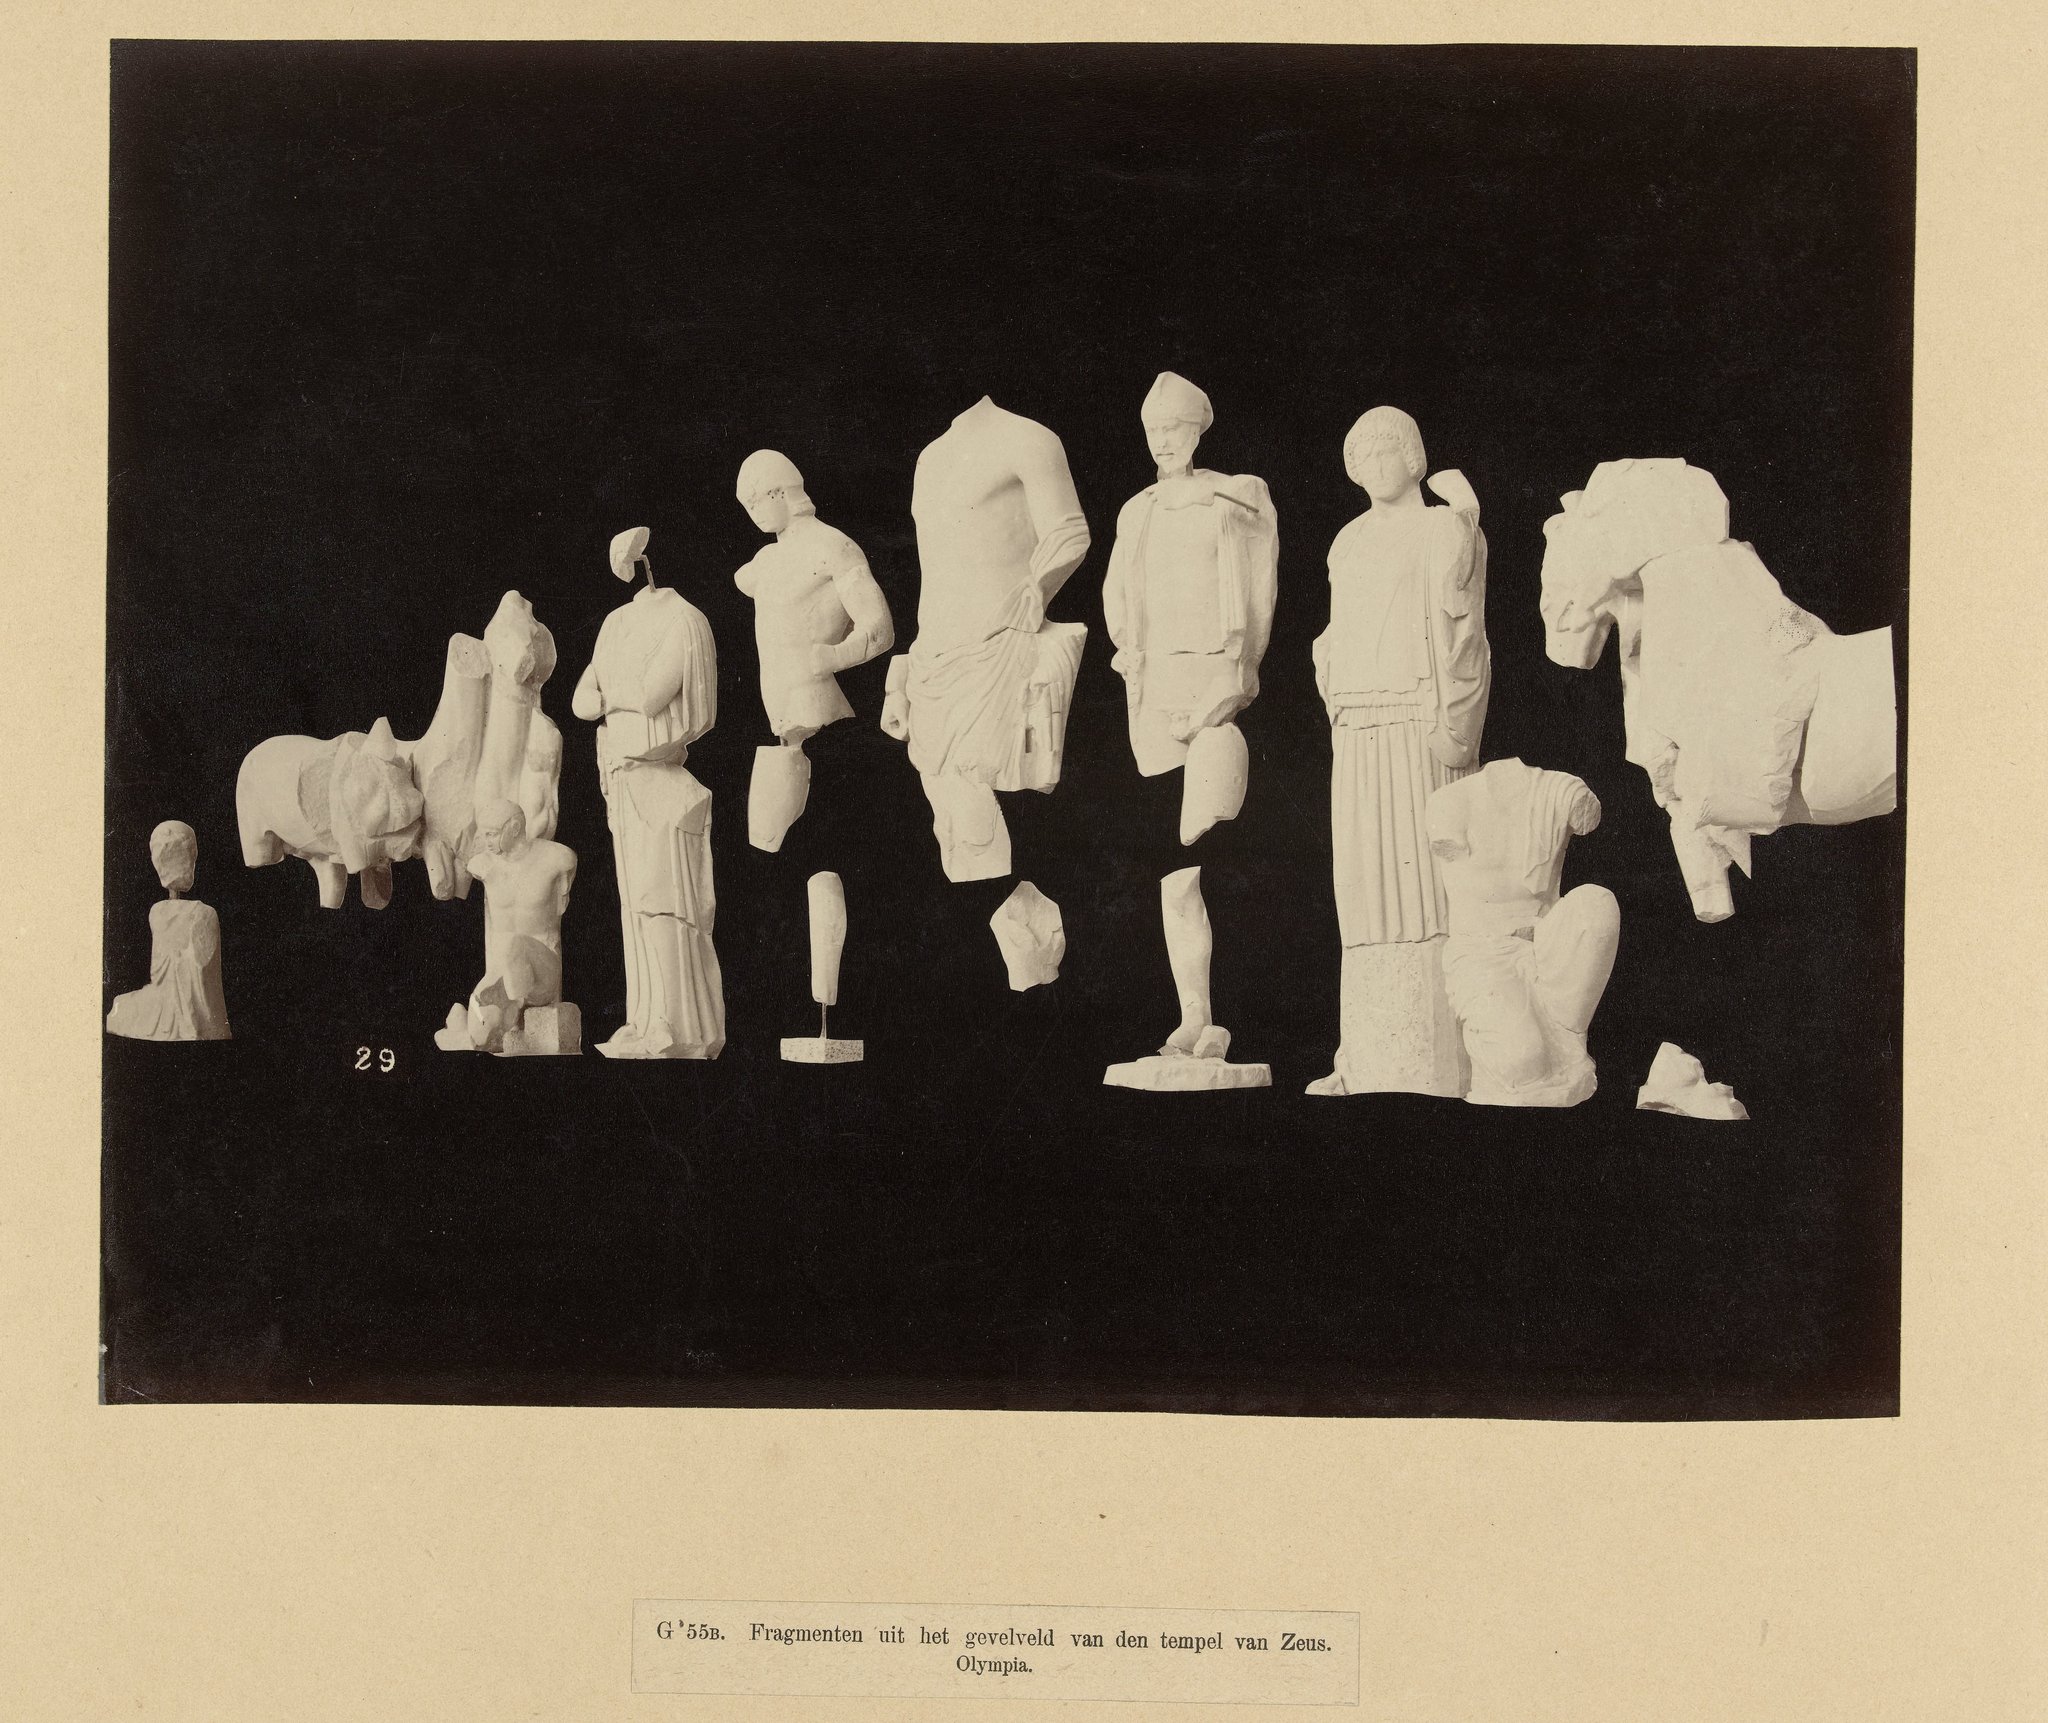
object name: photograph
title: G 55B. Fragmenten uit het gevelveld van den tempel van Zeus. Olympia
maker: Anonymous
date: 1890-1895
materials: cardboard, paper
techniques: albumen print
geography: olympia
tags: representations ~ gods, demi-gods, heroes, etc. (greek religion), piece of sculpture, reproduction of a piece of sculpture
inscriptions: number: ‘29’, stamp: ‘Gemeentelijke bibliotheek/ Rotterdam’, title: ‘G 55B. Fragmenten uit het gevelveld van den tempel van Zeus./ Olympia.’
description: Onderdeel van een groep door fotograaf Richard Polak op reis verzamelde foto’s. Deze foto is samen met andere op zijn reizen verzamelde foto's tentoongesteld bij de Rotterdamsche Kunstkring (1895), Arti en Amicitiae te Amsterdam (1897-1898?) en Societeit 't Collegie te Kampen (datum vooralsnog onbekend).